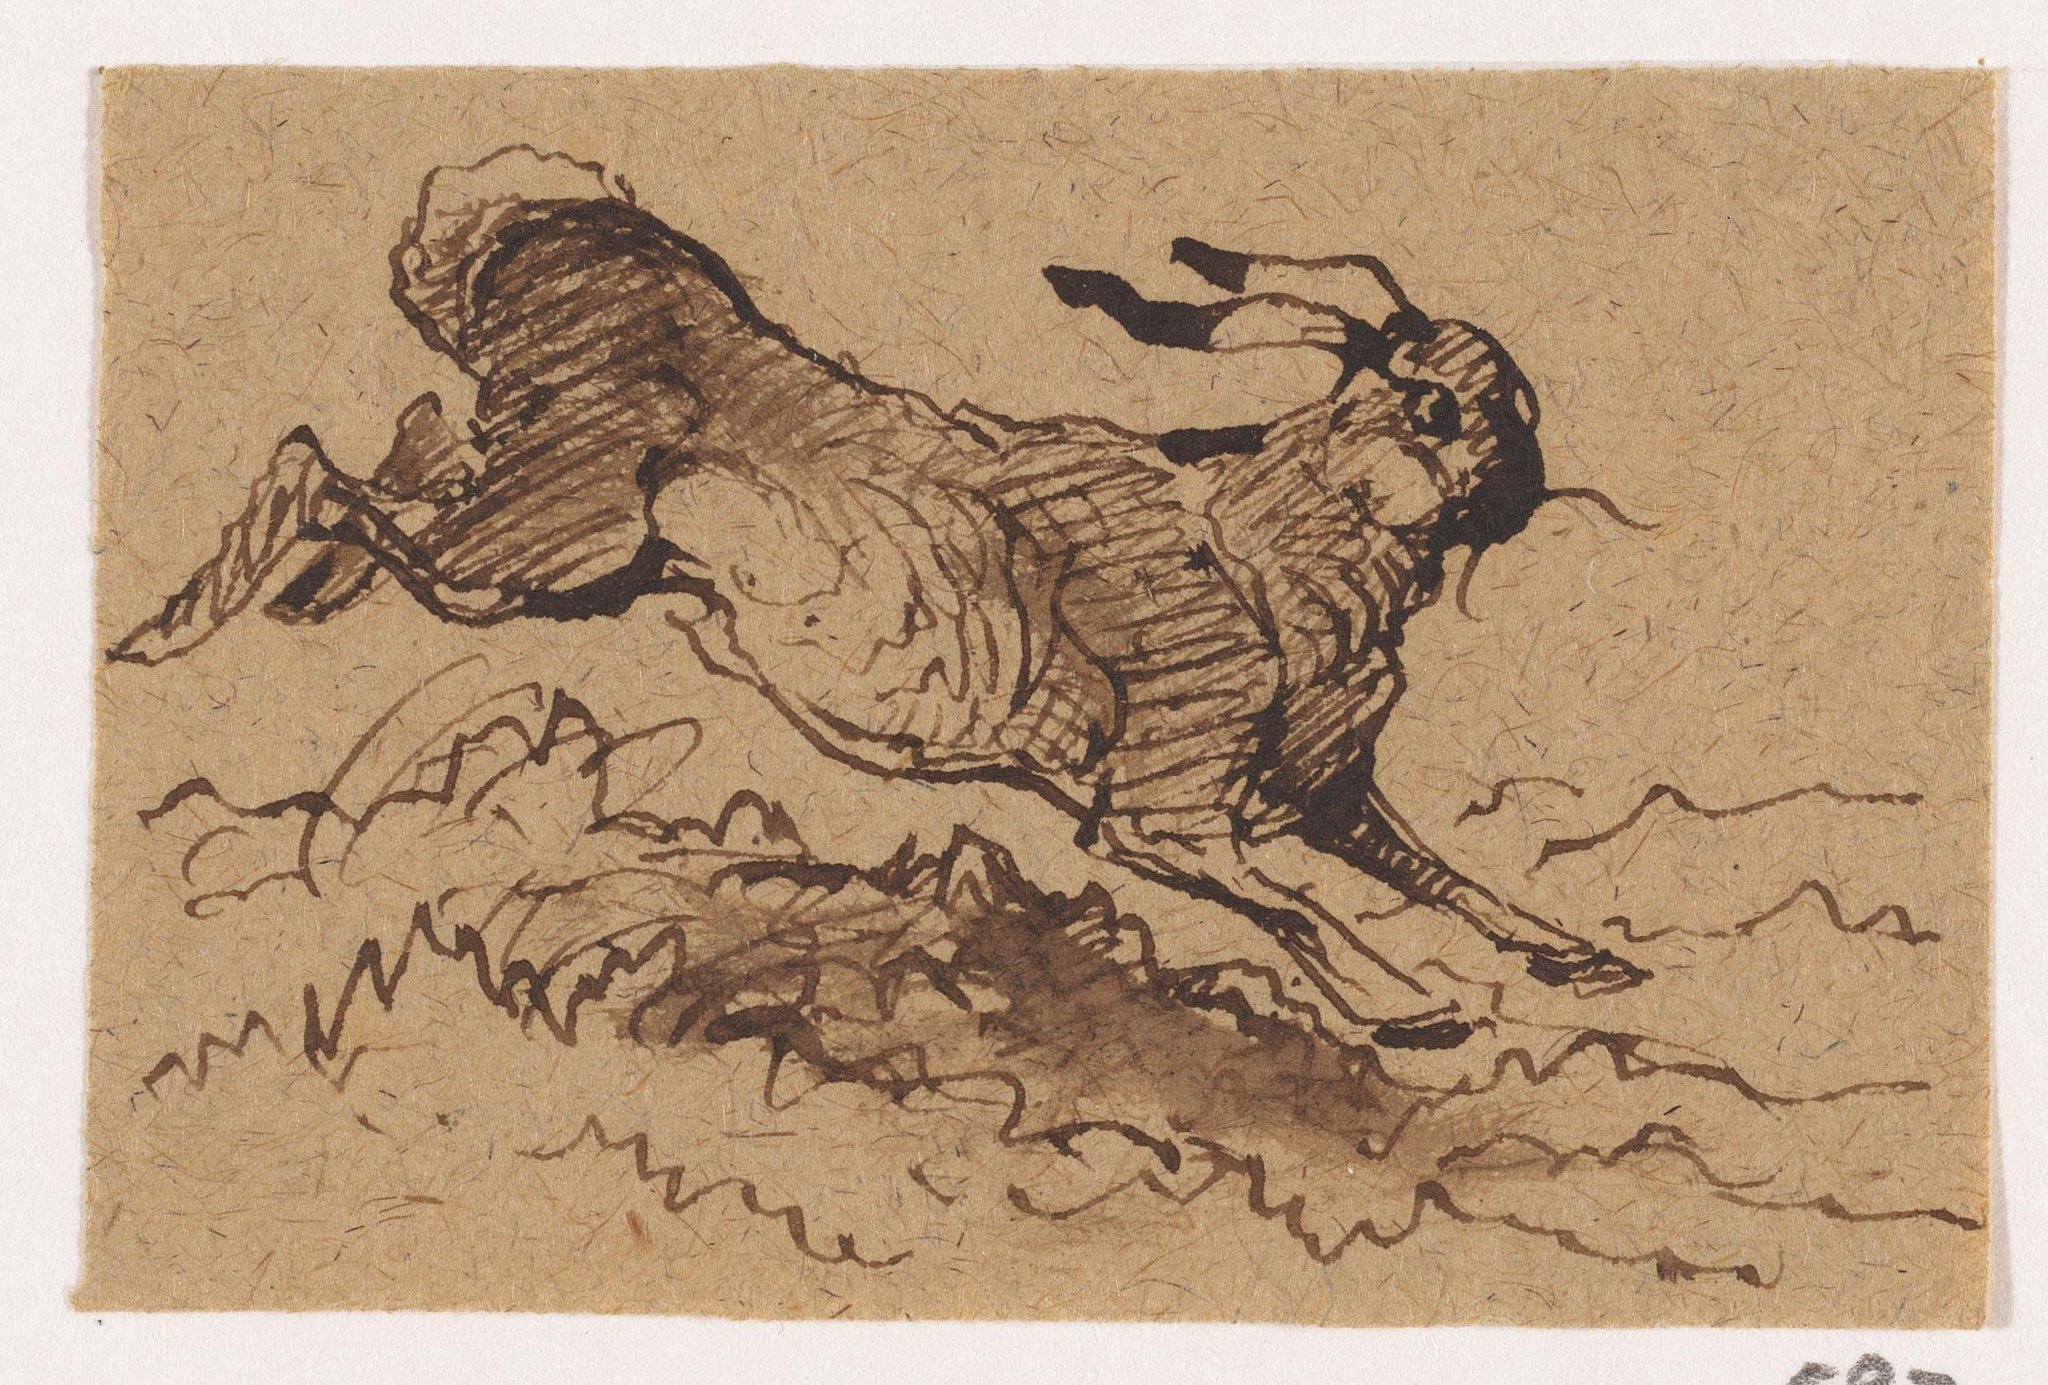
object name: drawing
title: Haas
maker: johannes tavenraat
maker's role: draughtsman, painter, print maker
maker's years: 1809-1881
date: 1840-1880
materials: ink, paper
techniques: pen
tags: rodents: hare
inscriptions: collector's mark: Lugt 2228, signature: ‘Tavenraat’